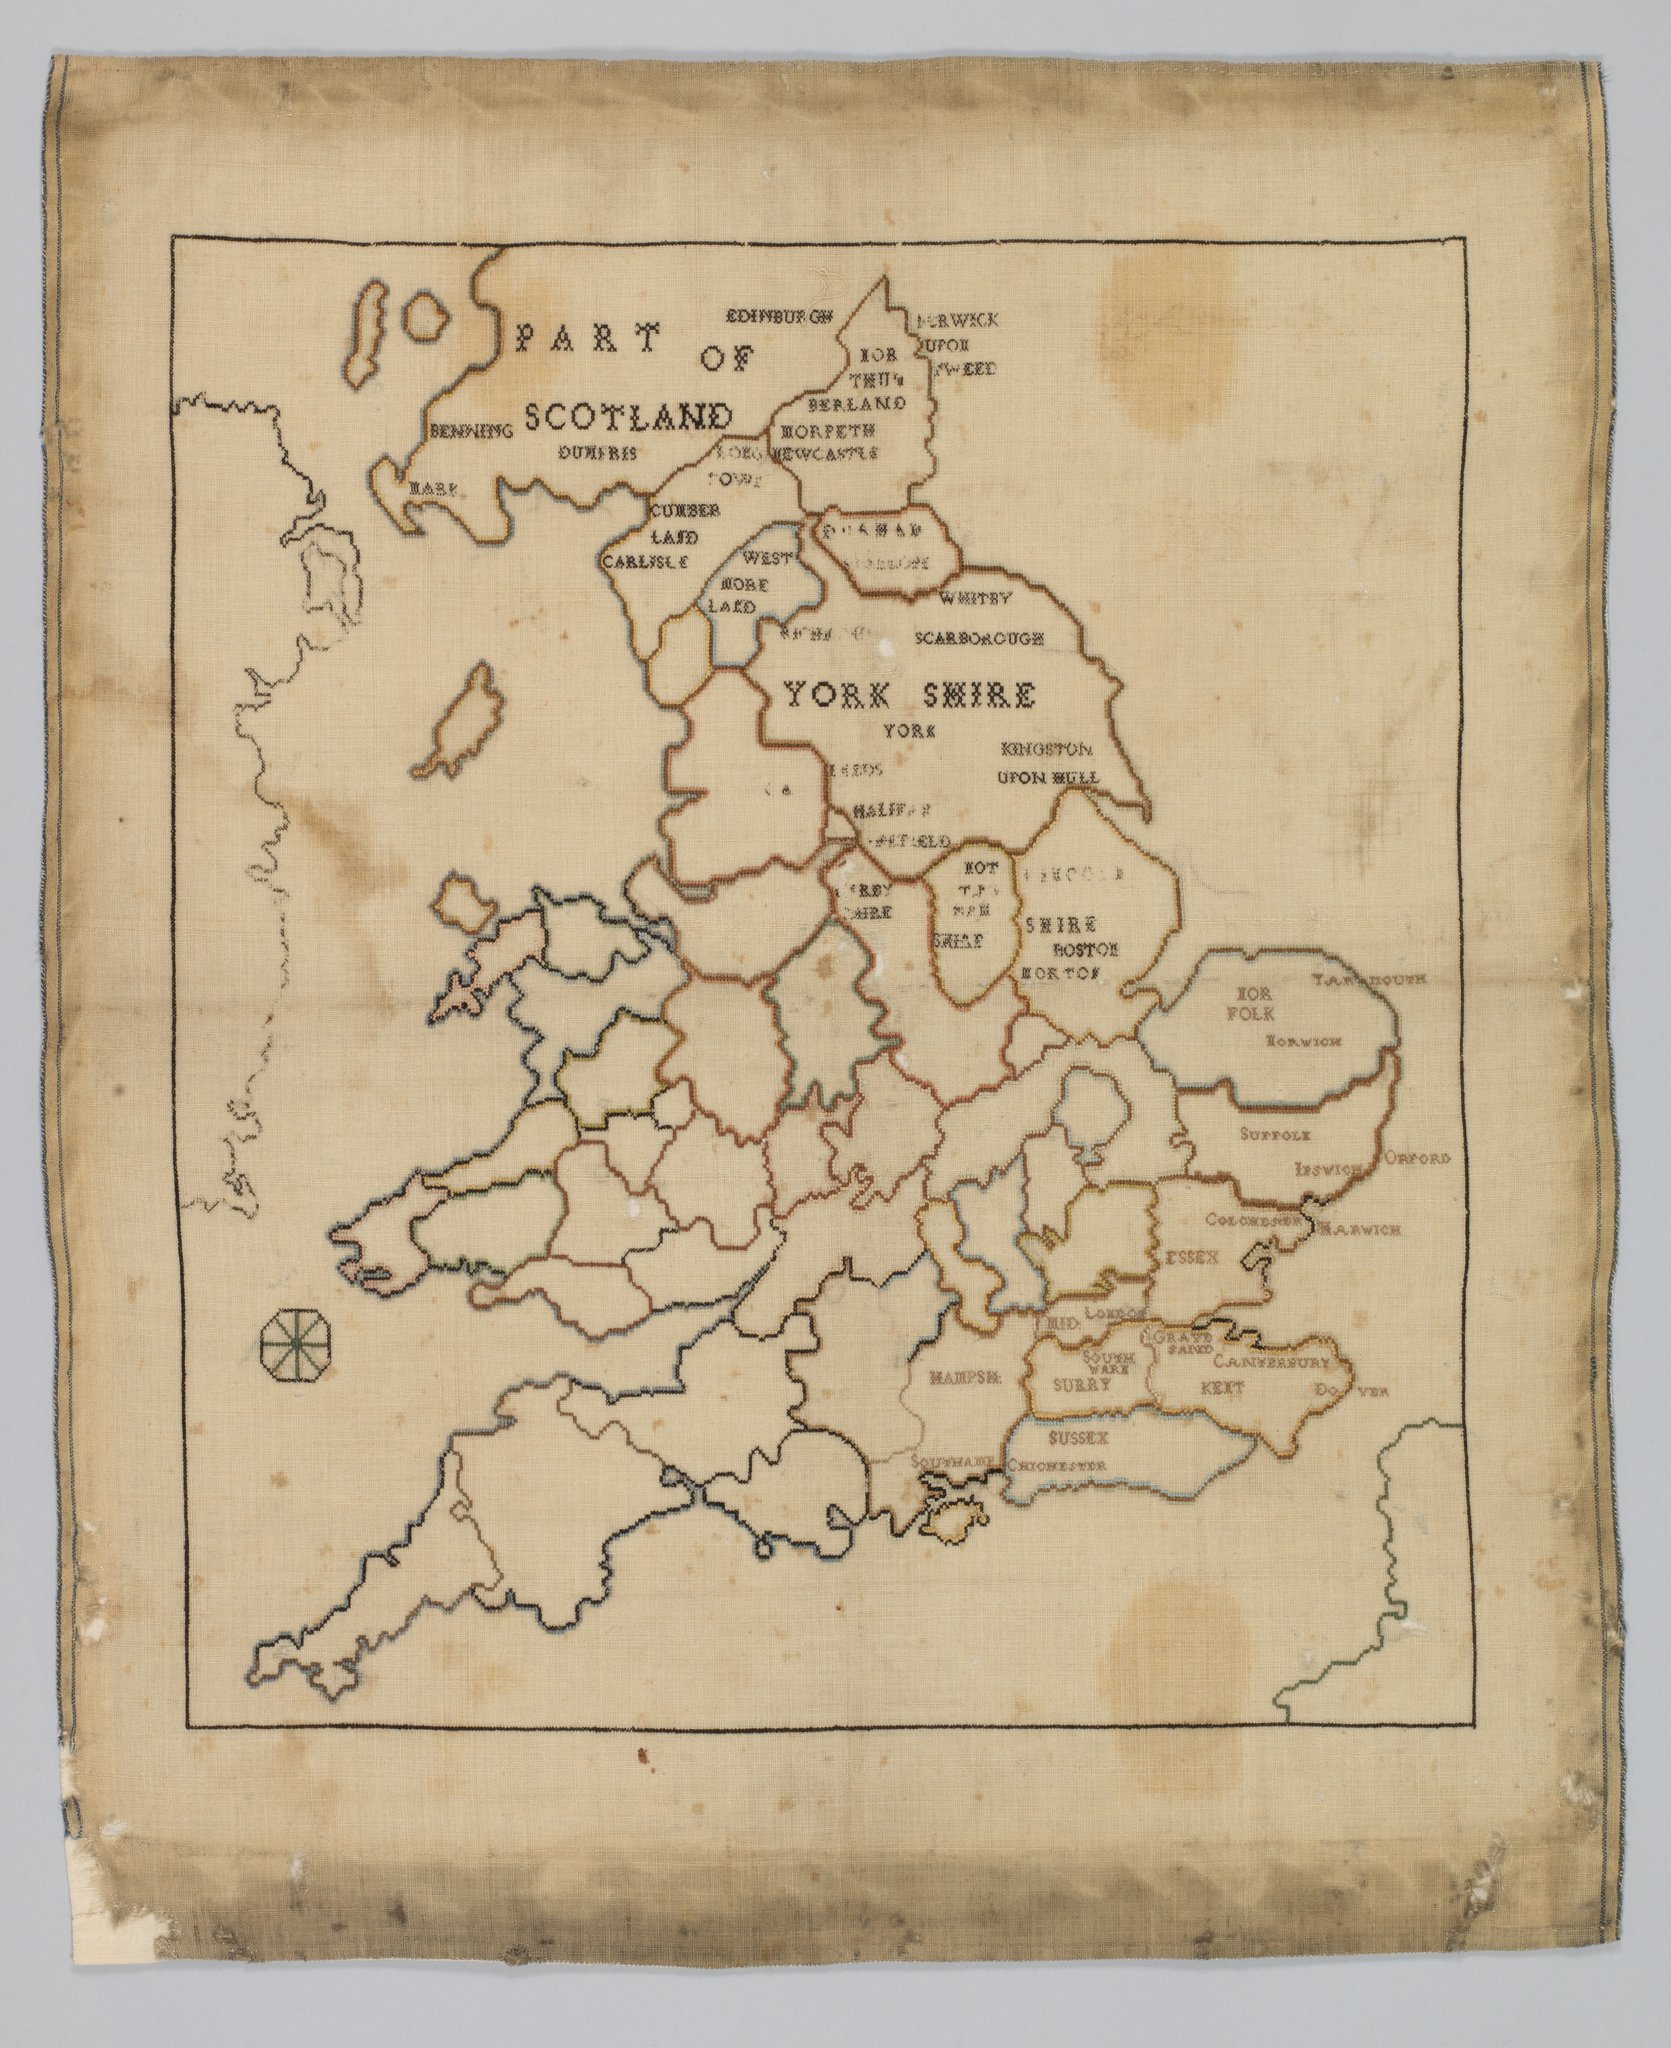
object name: sampler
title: Embroidered map sampler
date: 1767-1900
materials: canvas, silk, wool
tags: maps